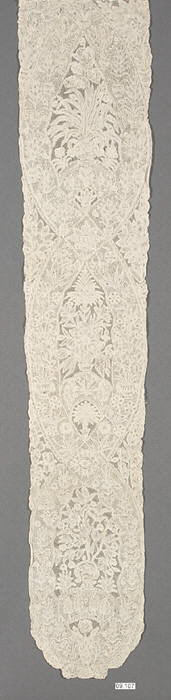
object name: lappet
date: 1701-1733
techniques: lace